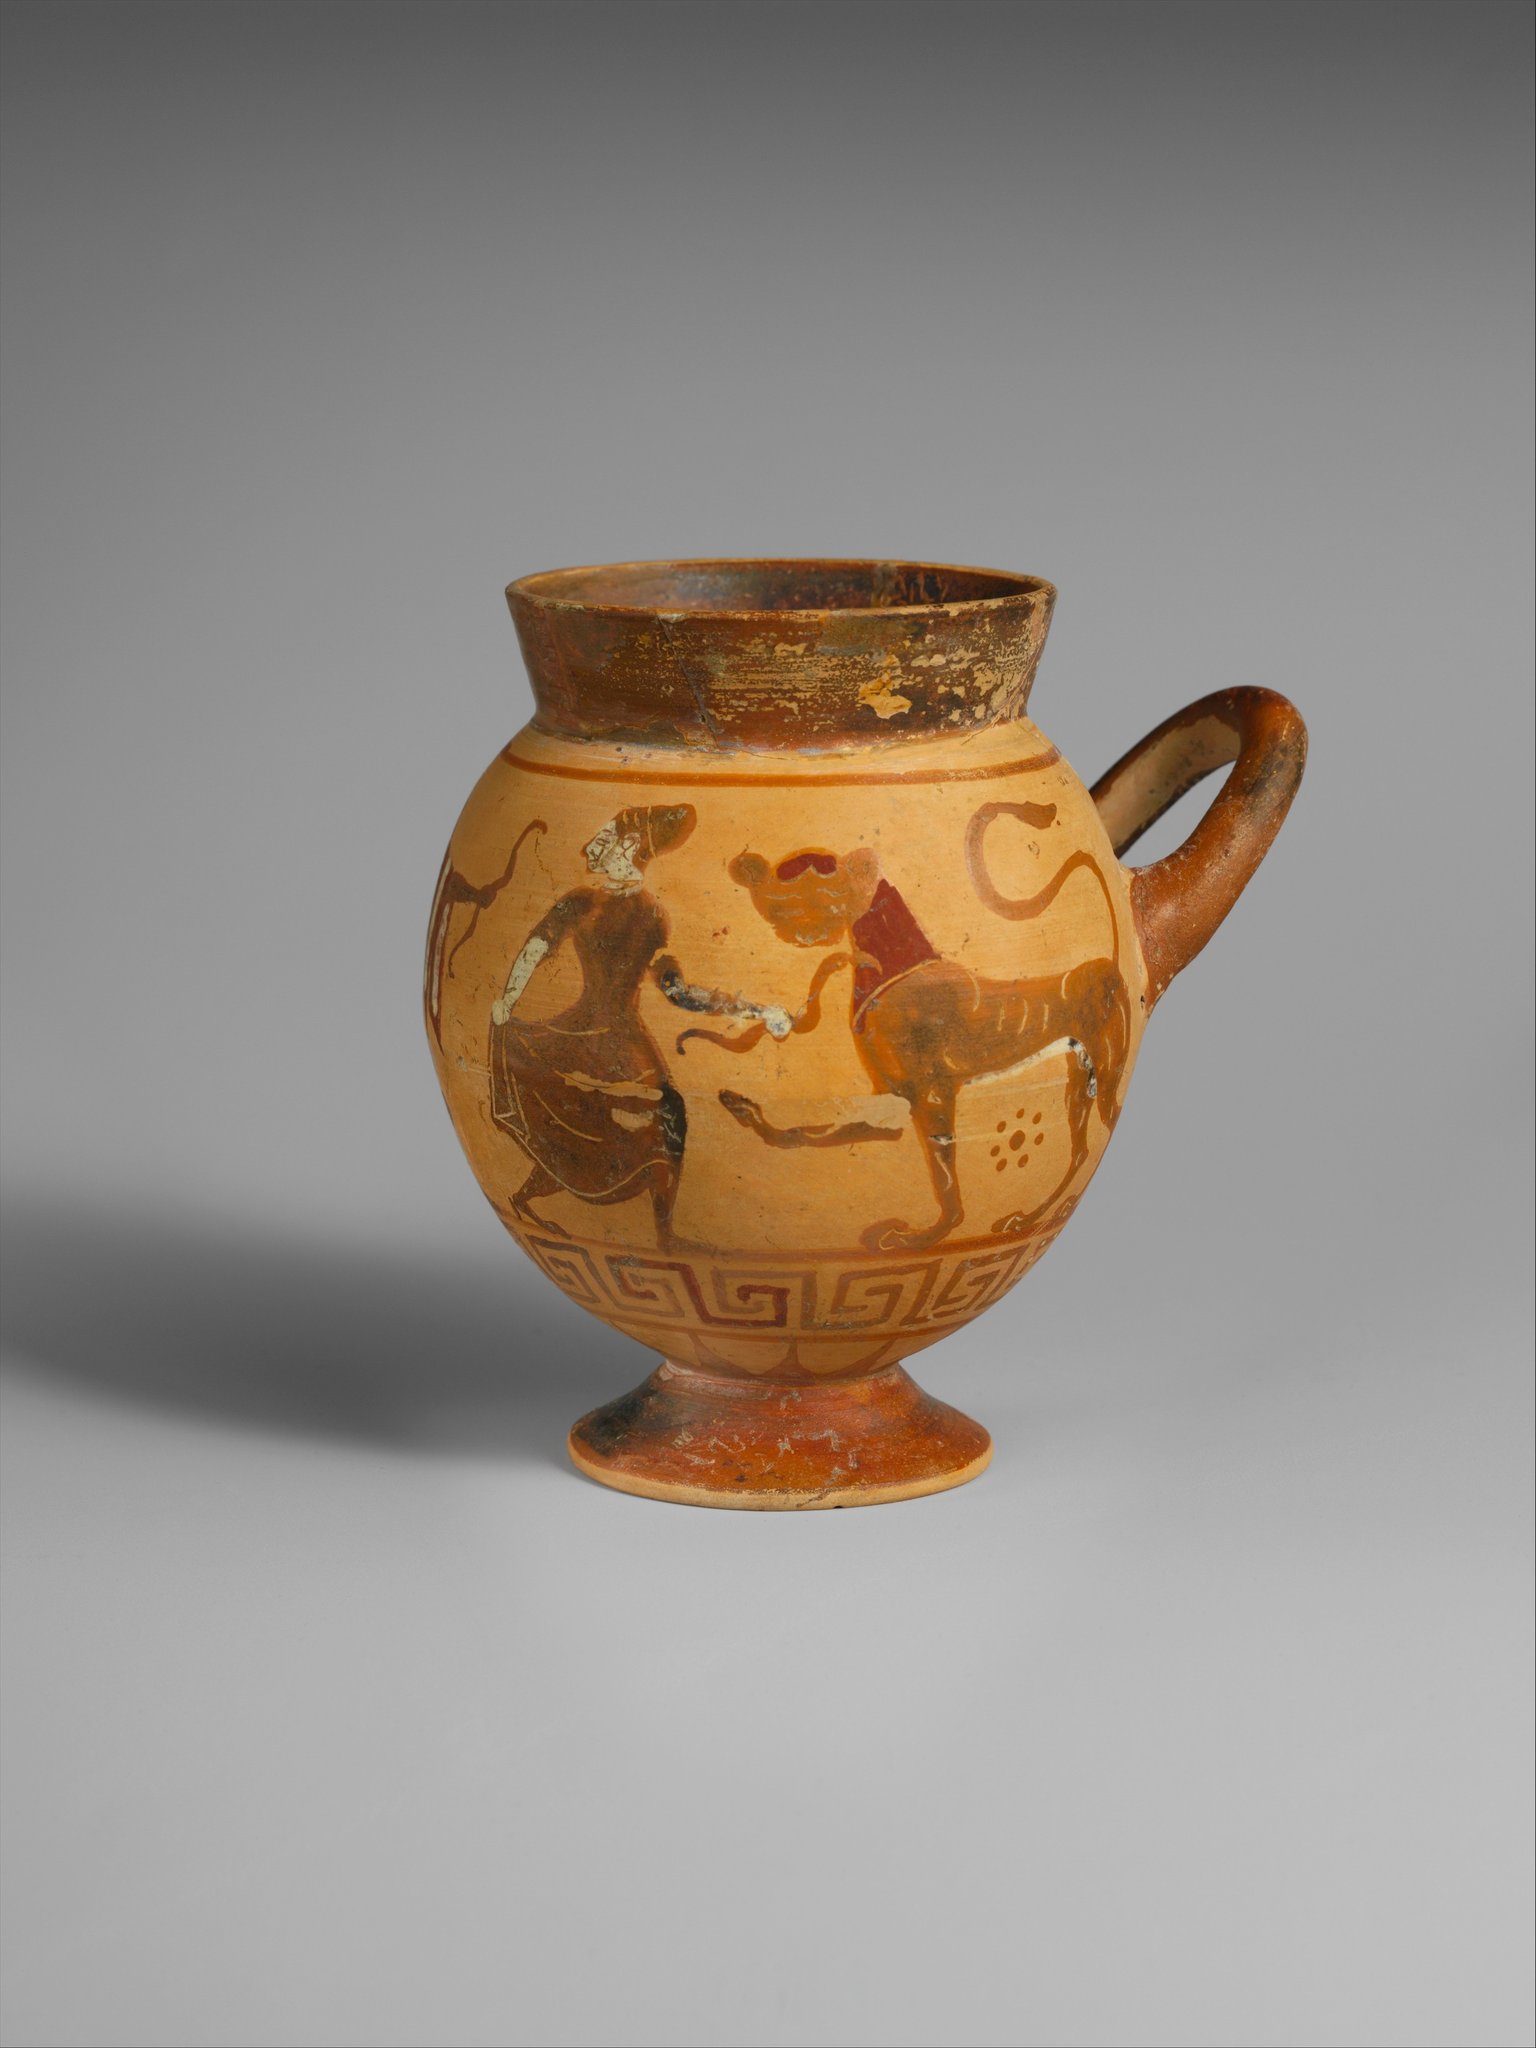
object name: cup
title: Terracotta globular cup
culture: etruscan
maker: tityos painter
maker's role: artist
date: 520-510 BCE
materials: terracotta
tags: men,women,lions